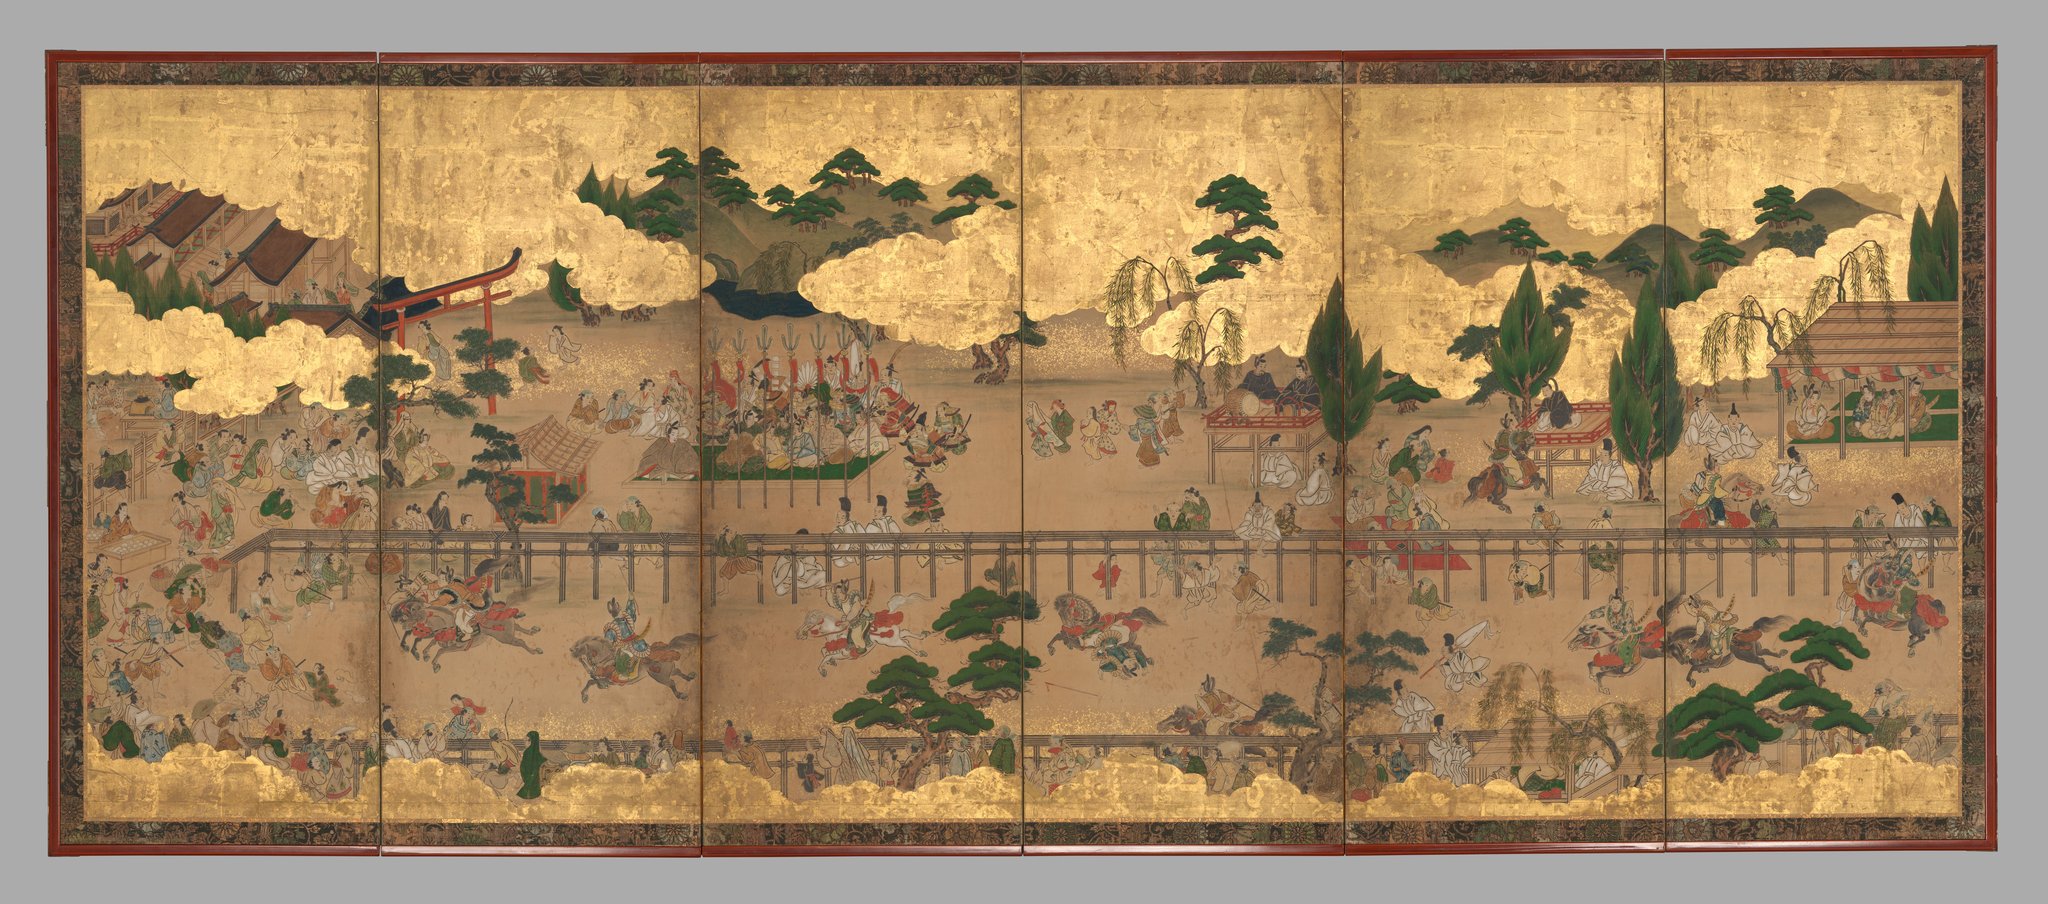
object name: screen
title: Horse Racing at Kamo Shrine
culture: japanese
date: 1667-1733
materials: gold, gold leaf, ink, panel, paper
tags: men,women,horses